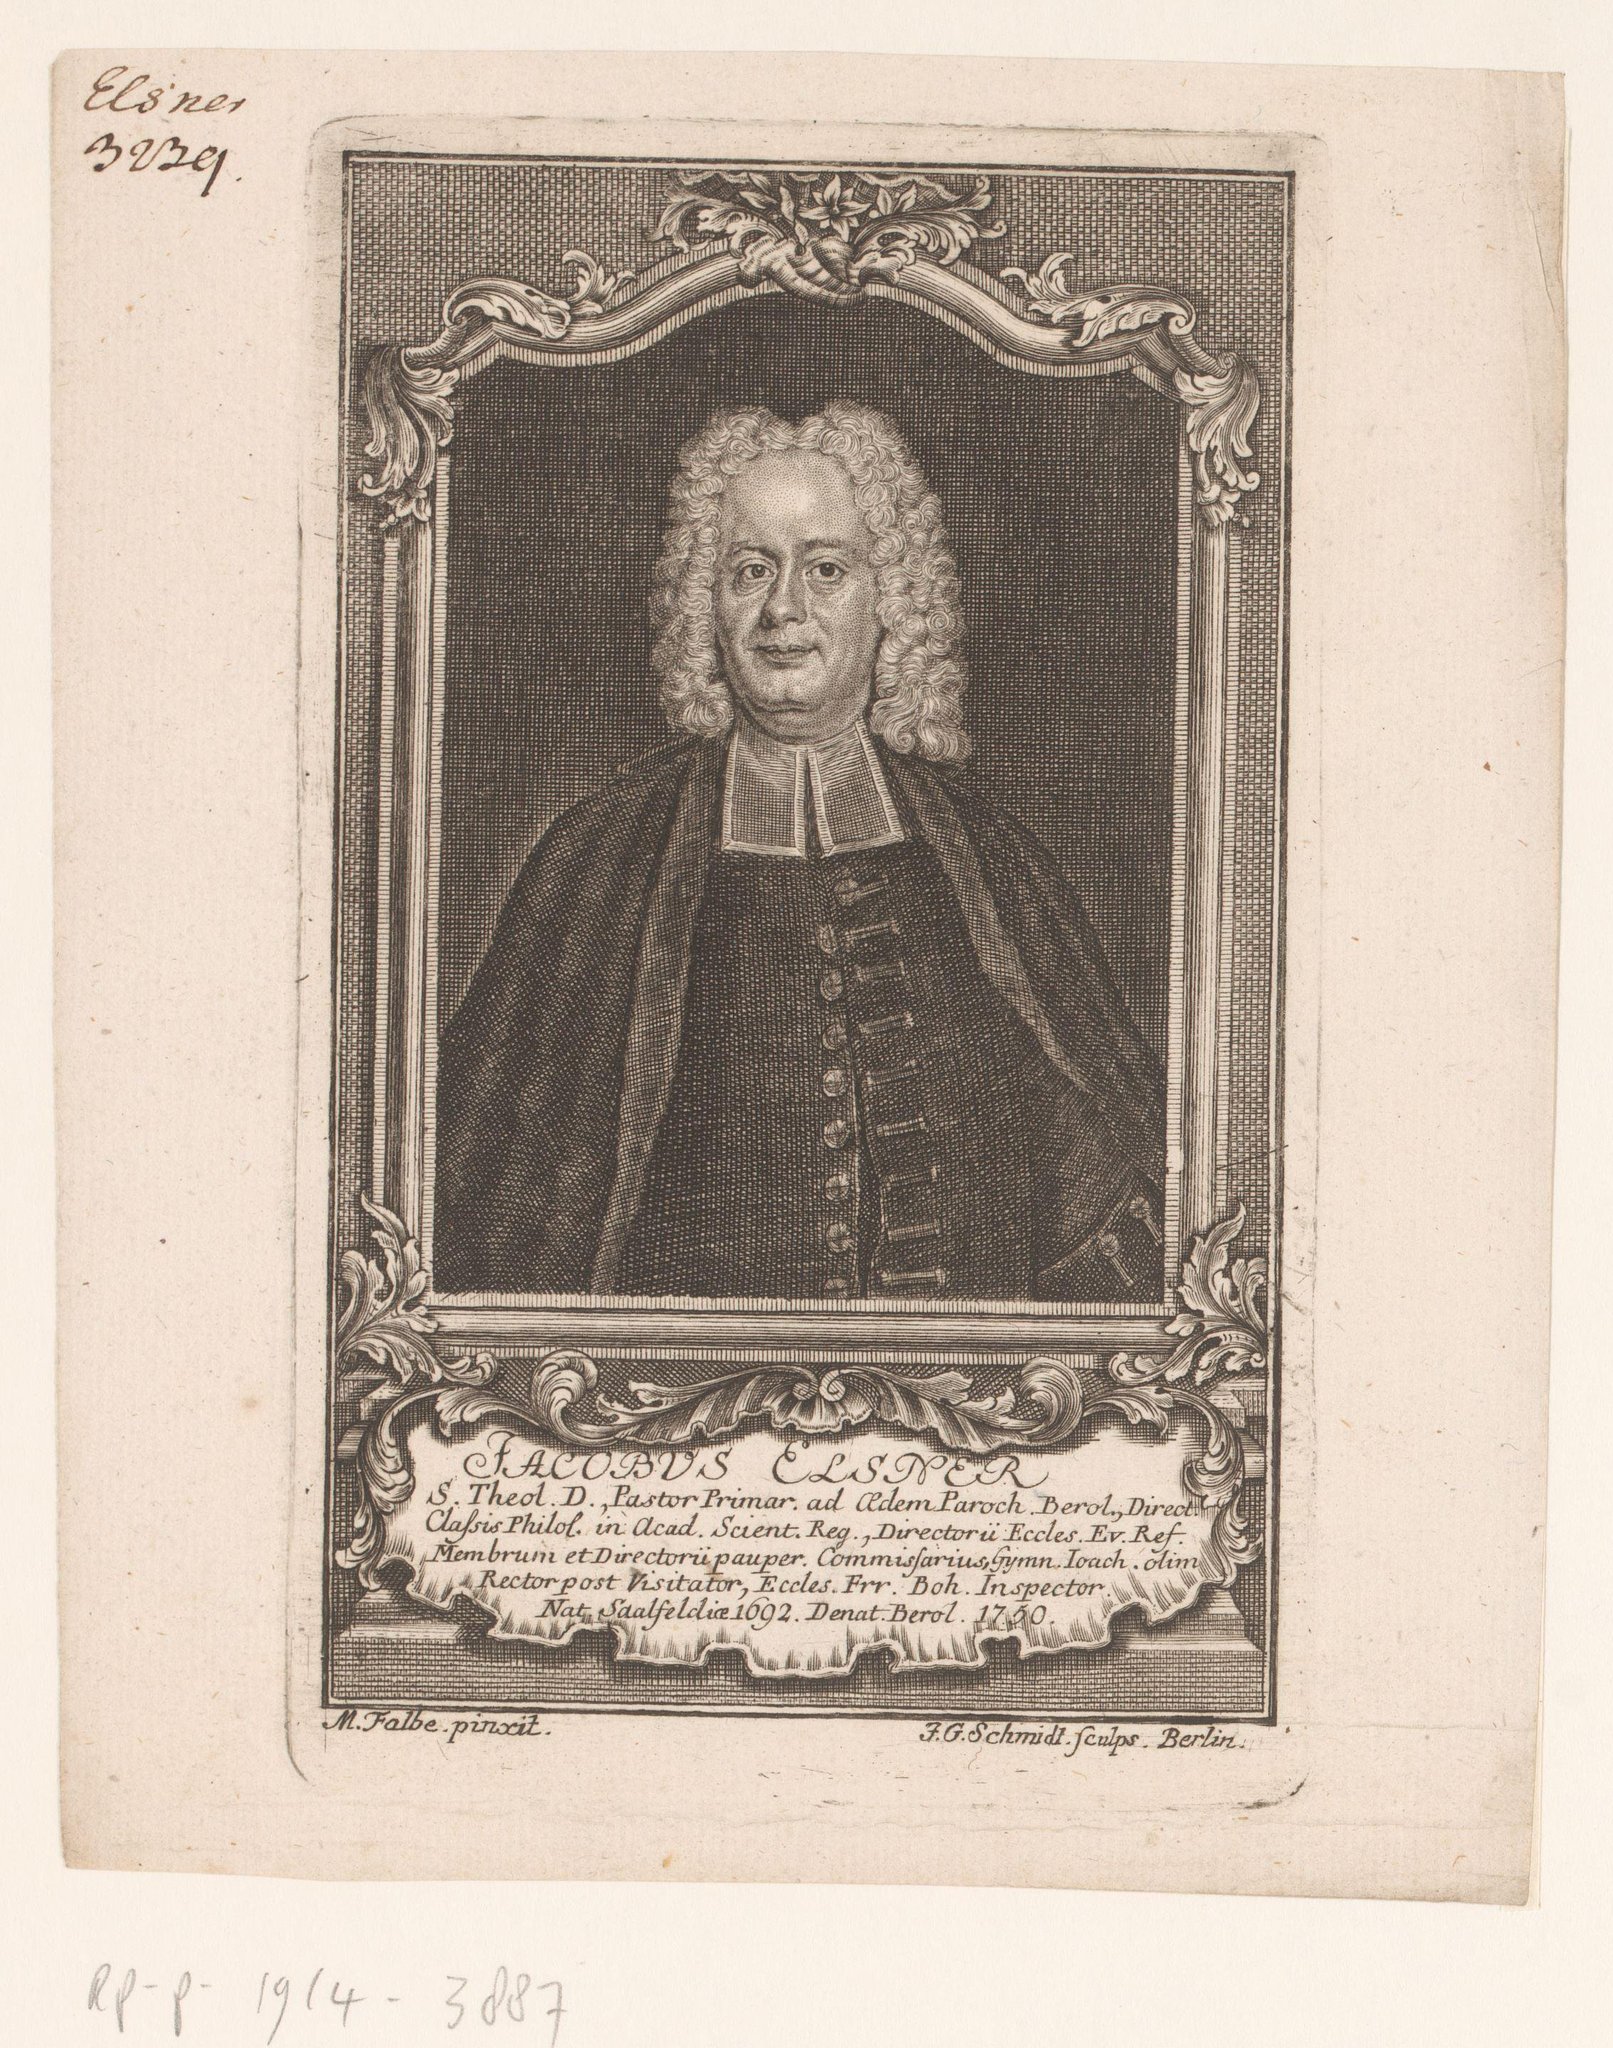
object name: print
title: Portret van Jakob Elsner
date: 1750-1765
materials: paper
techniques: engraving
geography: berlin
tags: berlin, historical persons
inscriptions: collector's mark: Lugt 2228